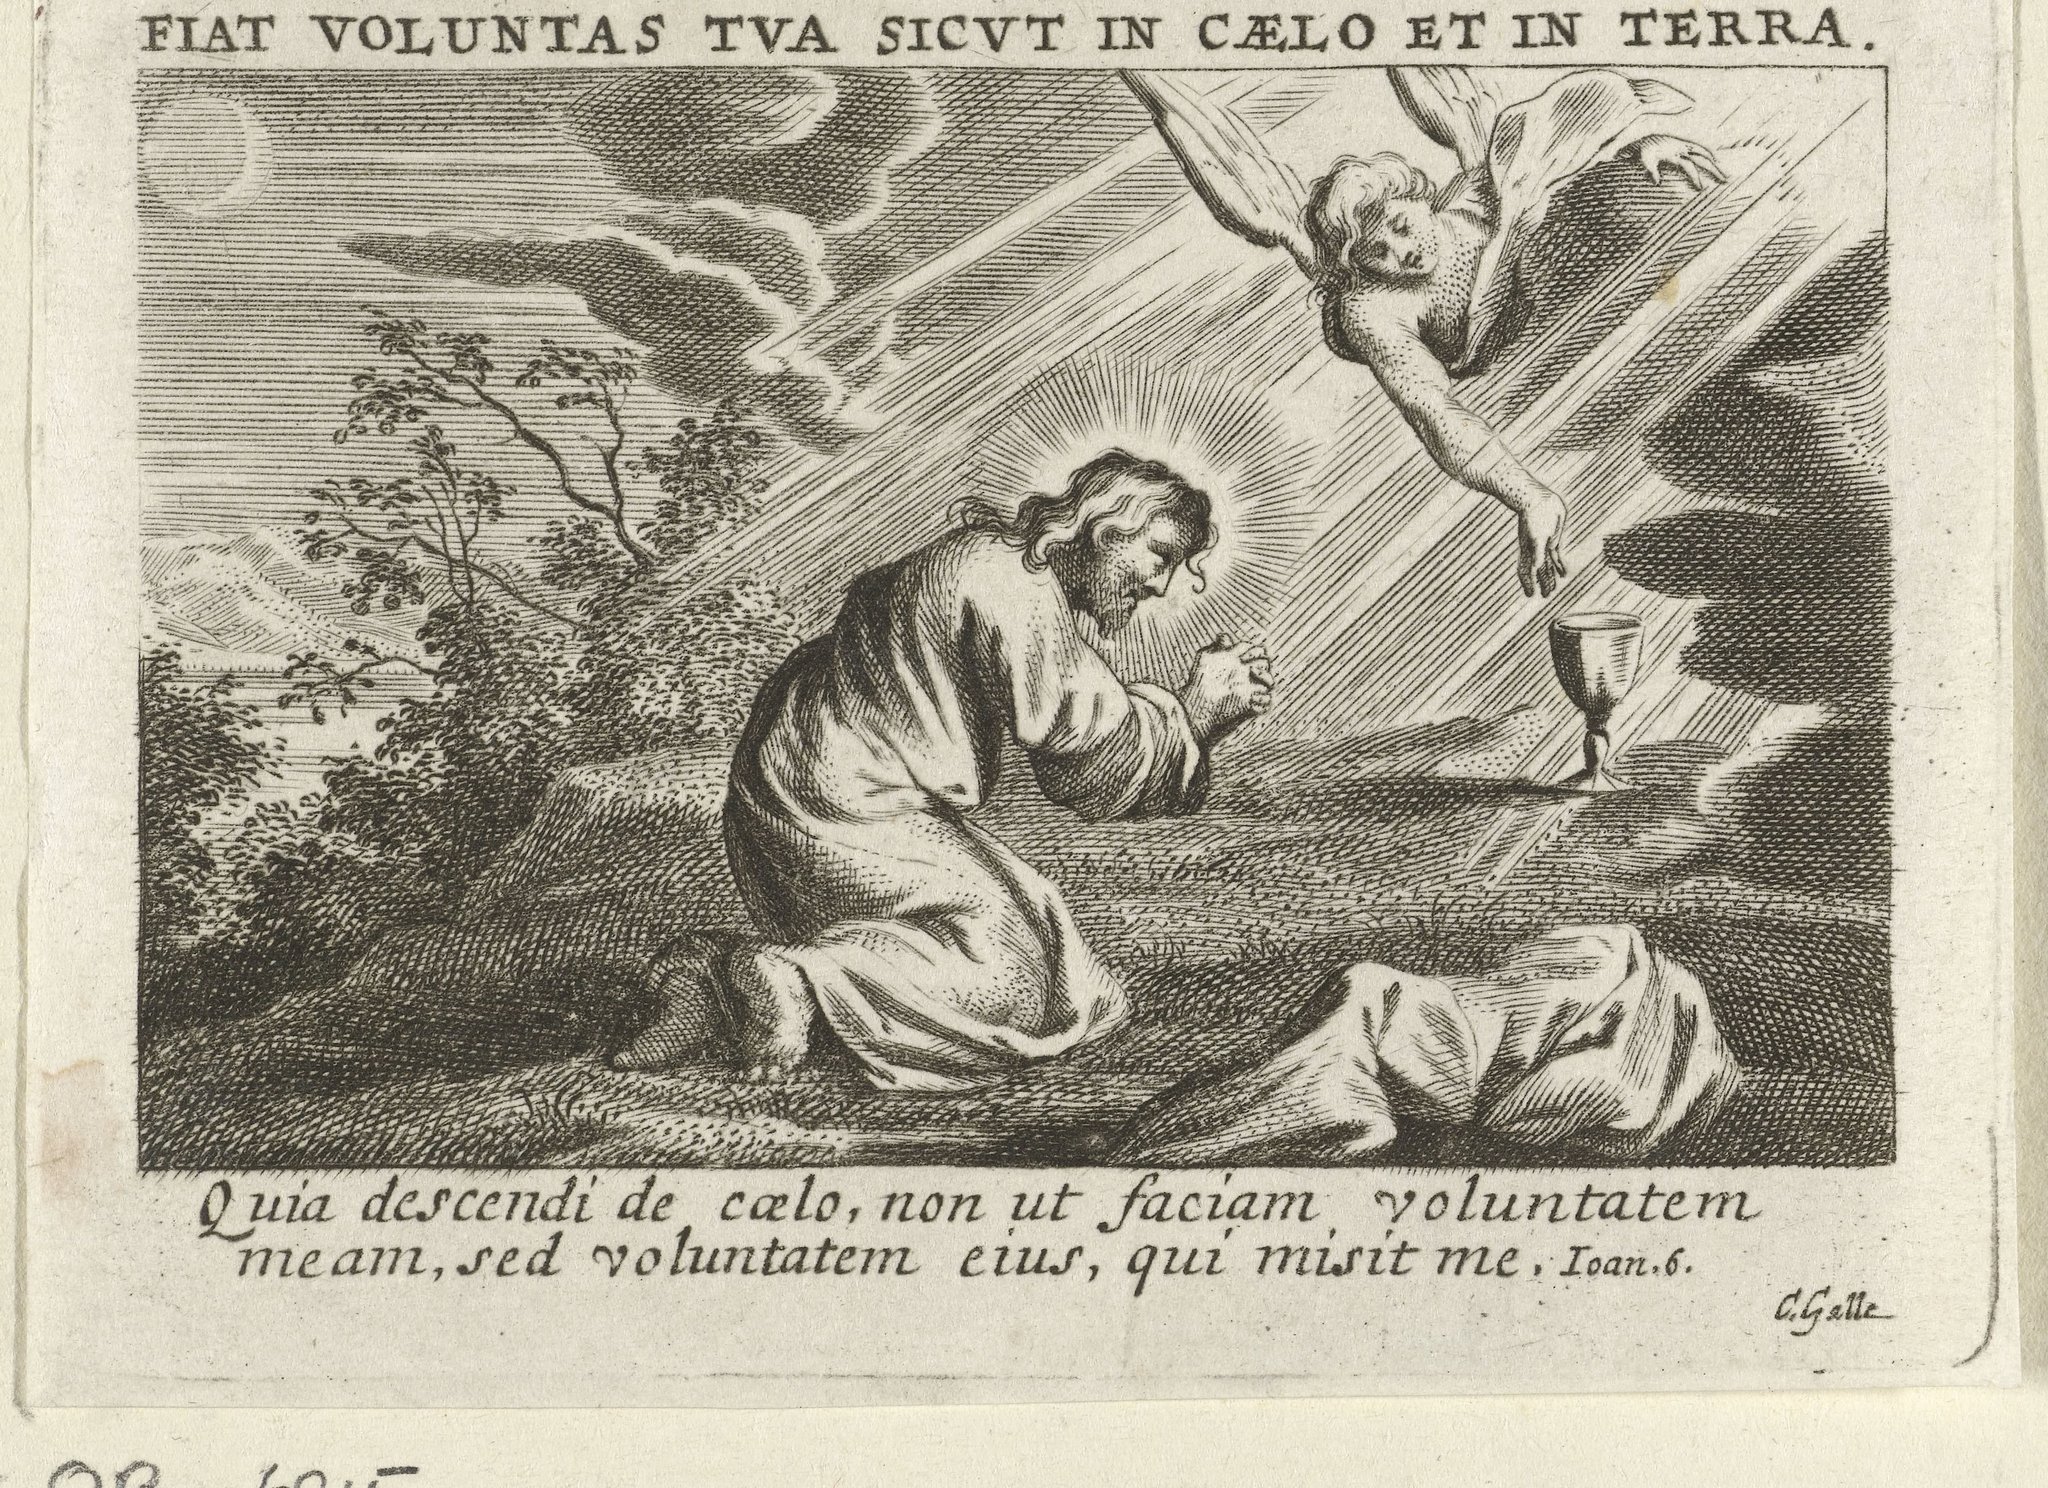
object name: print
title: Christus in de hof van Getsemane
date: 1638-1678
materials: paper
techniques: engraving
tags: agony of christ: to comfort him one or more angels appear to christ with chalice and/or cross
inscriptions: collector's mark: Lugt 240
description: Christus knielt 's nachts op de olijfberg en bidt. Een engel brengt hem een kelk. Onder de voorstelling een Latijns vers uit Joh. 6.